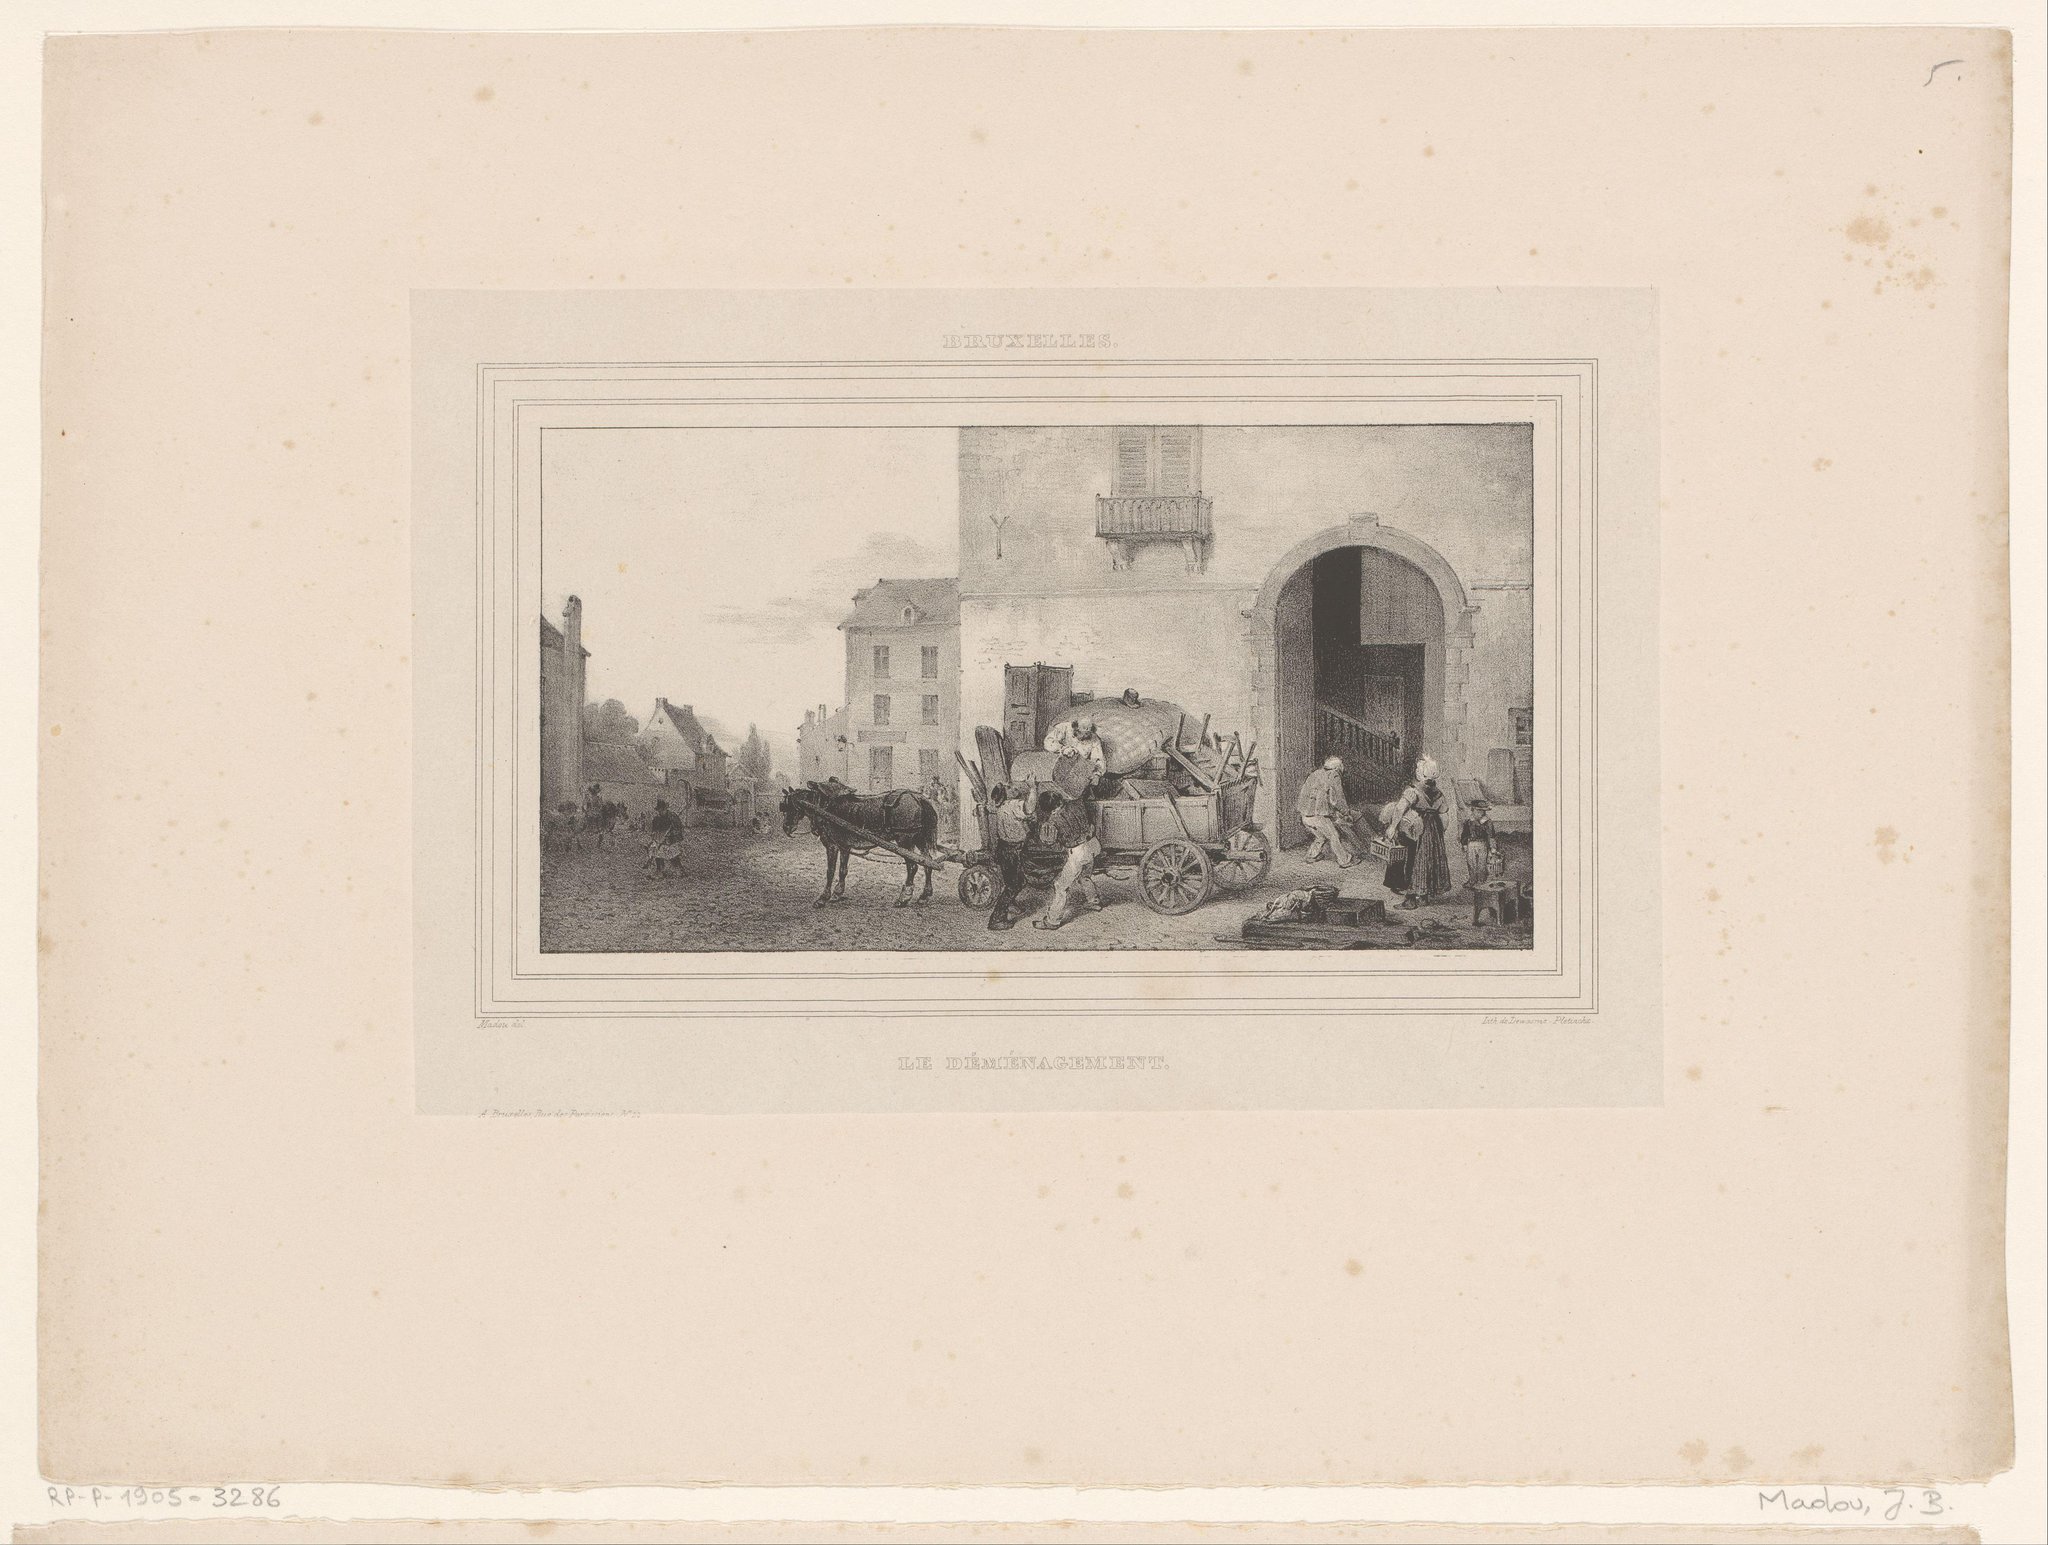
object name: print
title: Bruxelles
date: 1831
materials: paper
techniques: lithograph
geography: brussels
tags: moving (house), four-wheeled vehicle drawn by one animal, public road in village, brussels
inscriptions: collector's mark: Lugt 2228